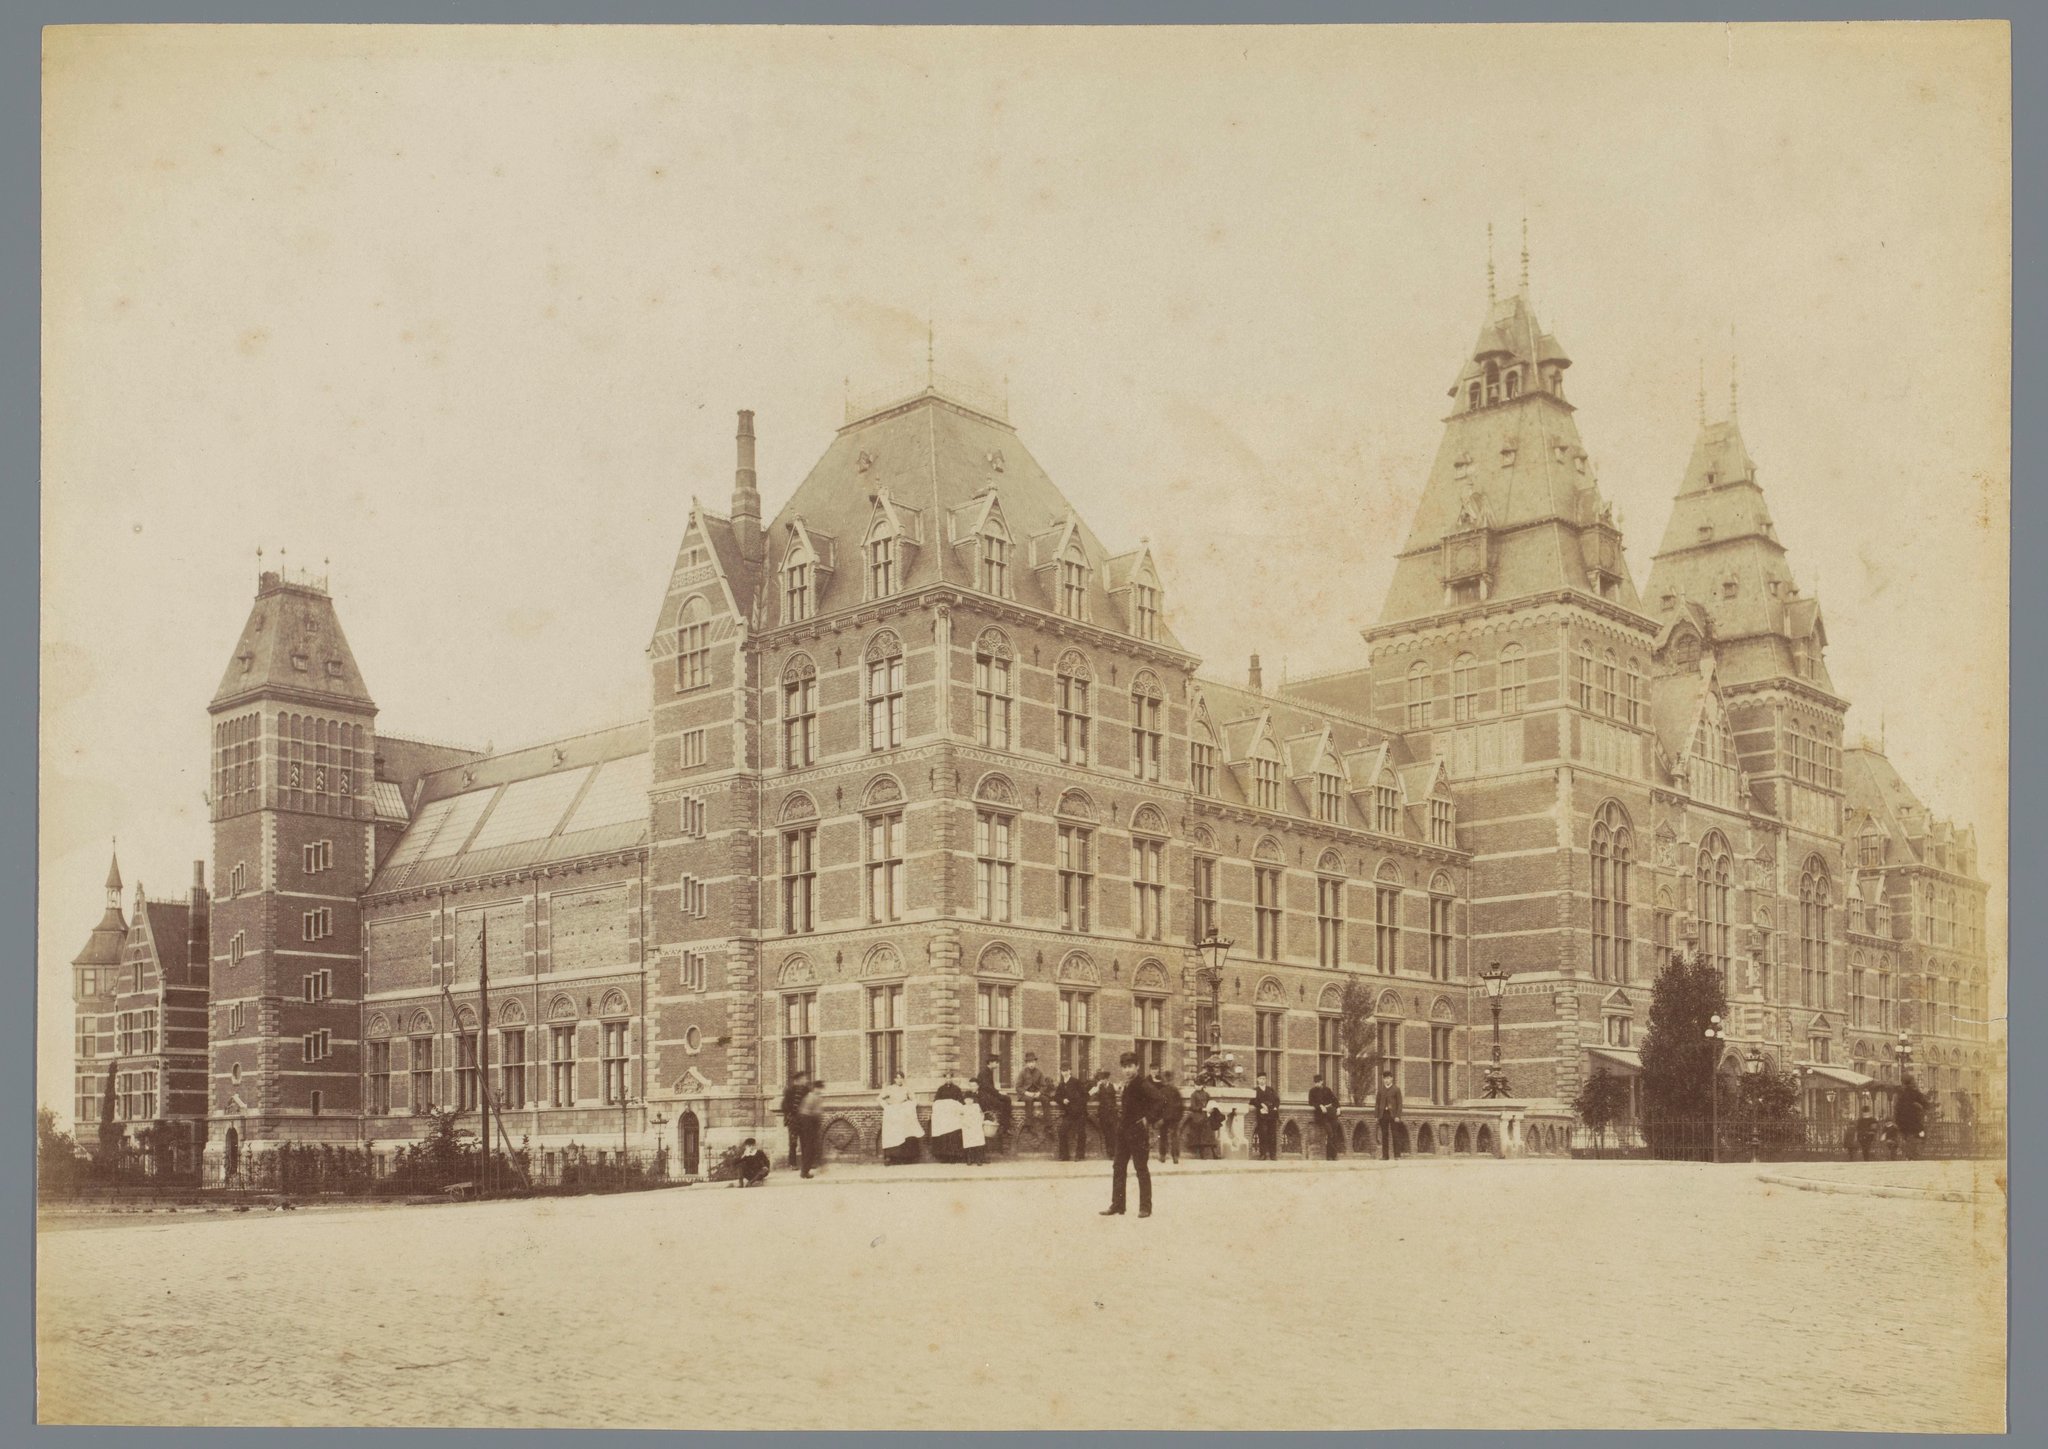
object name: photograph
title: Gezicht op het Rijksmuseum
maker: Anonymous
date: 1890-1910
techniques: albumen print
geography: amsterdam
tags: permanent exhibition, museum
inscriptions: inscription: ‘no. 3 Rijksmuseum Amsterdam’